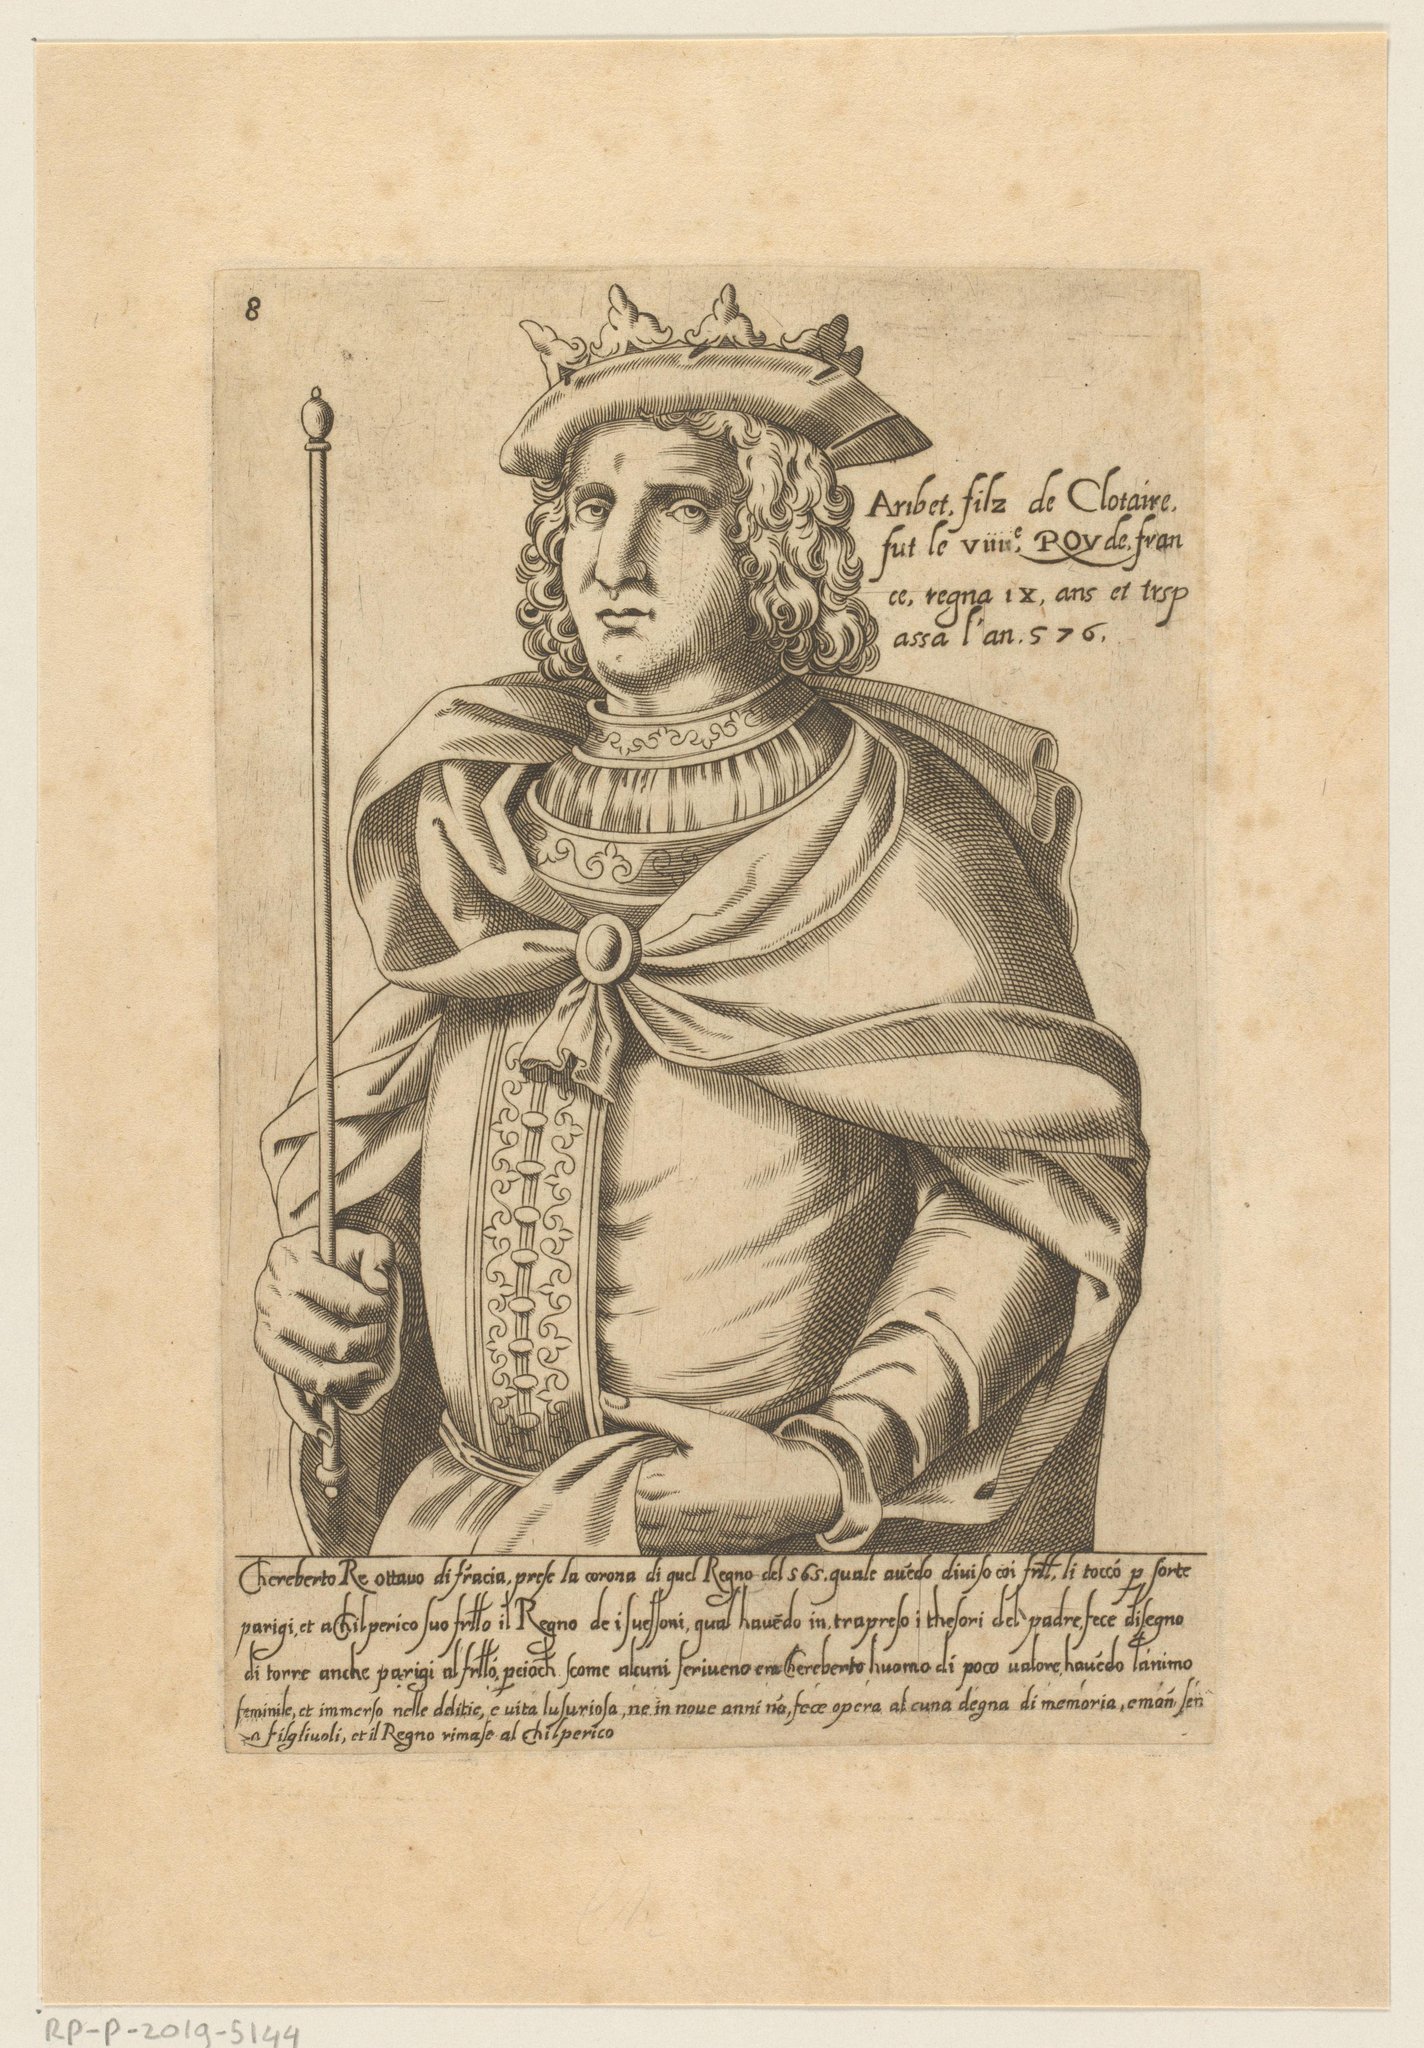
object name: book illustration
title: Portret van Charibert I, koning der Franken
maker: Anonymous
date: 1588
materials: paper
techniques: engraving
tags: crown (symbol of sovereignty), sceptre, staff (symbol of sovereignty), historical persons, king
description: Prent voor het eerst gebruikt in: Cronica Breve de i fatti illustri de're di Francia, con le loro effigie dal naturale cominciando da Faramondo (...). Venetië: Bernardo Giunti, 1588. Prent in ieder geval ook gebruikt in de editie van 1590 en mogelijk ook in een Franse uitgave van 1597.